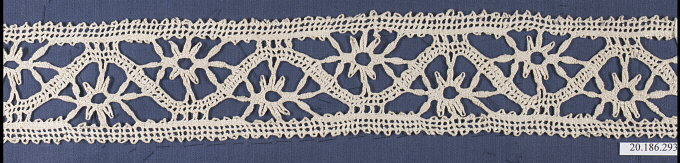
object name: fragment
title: Fragment of lace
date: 1601-1700